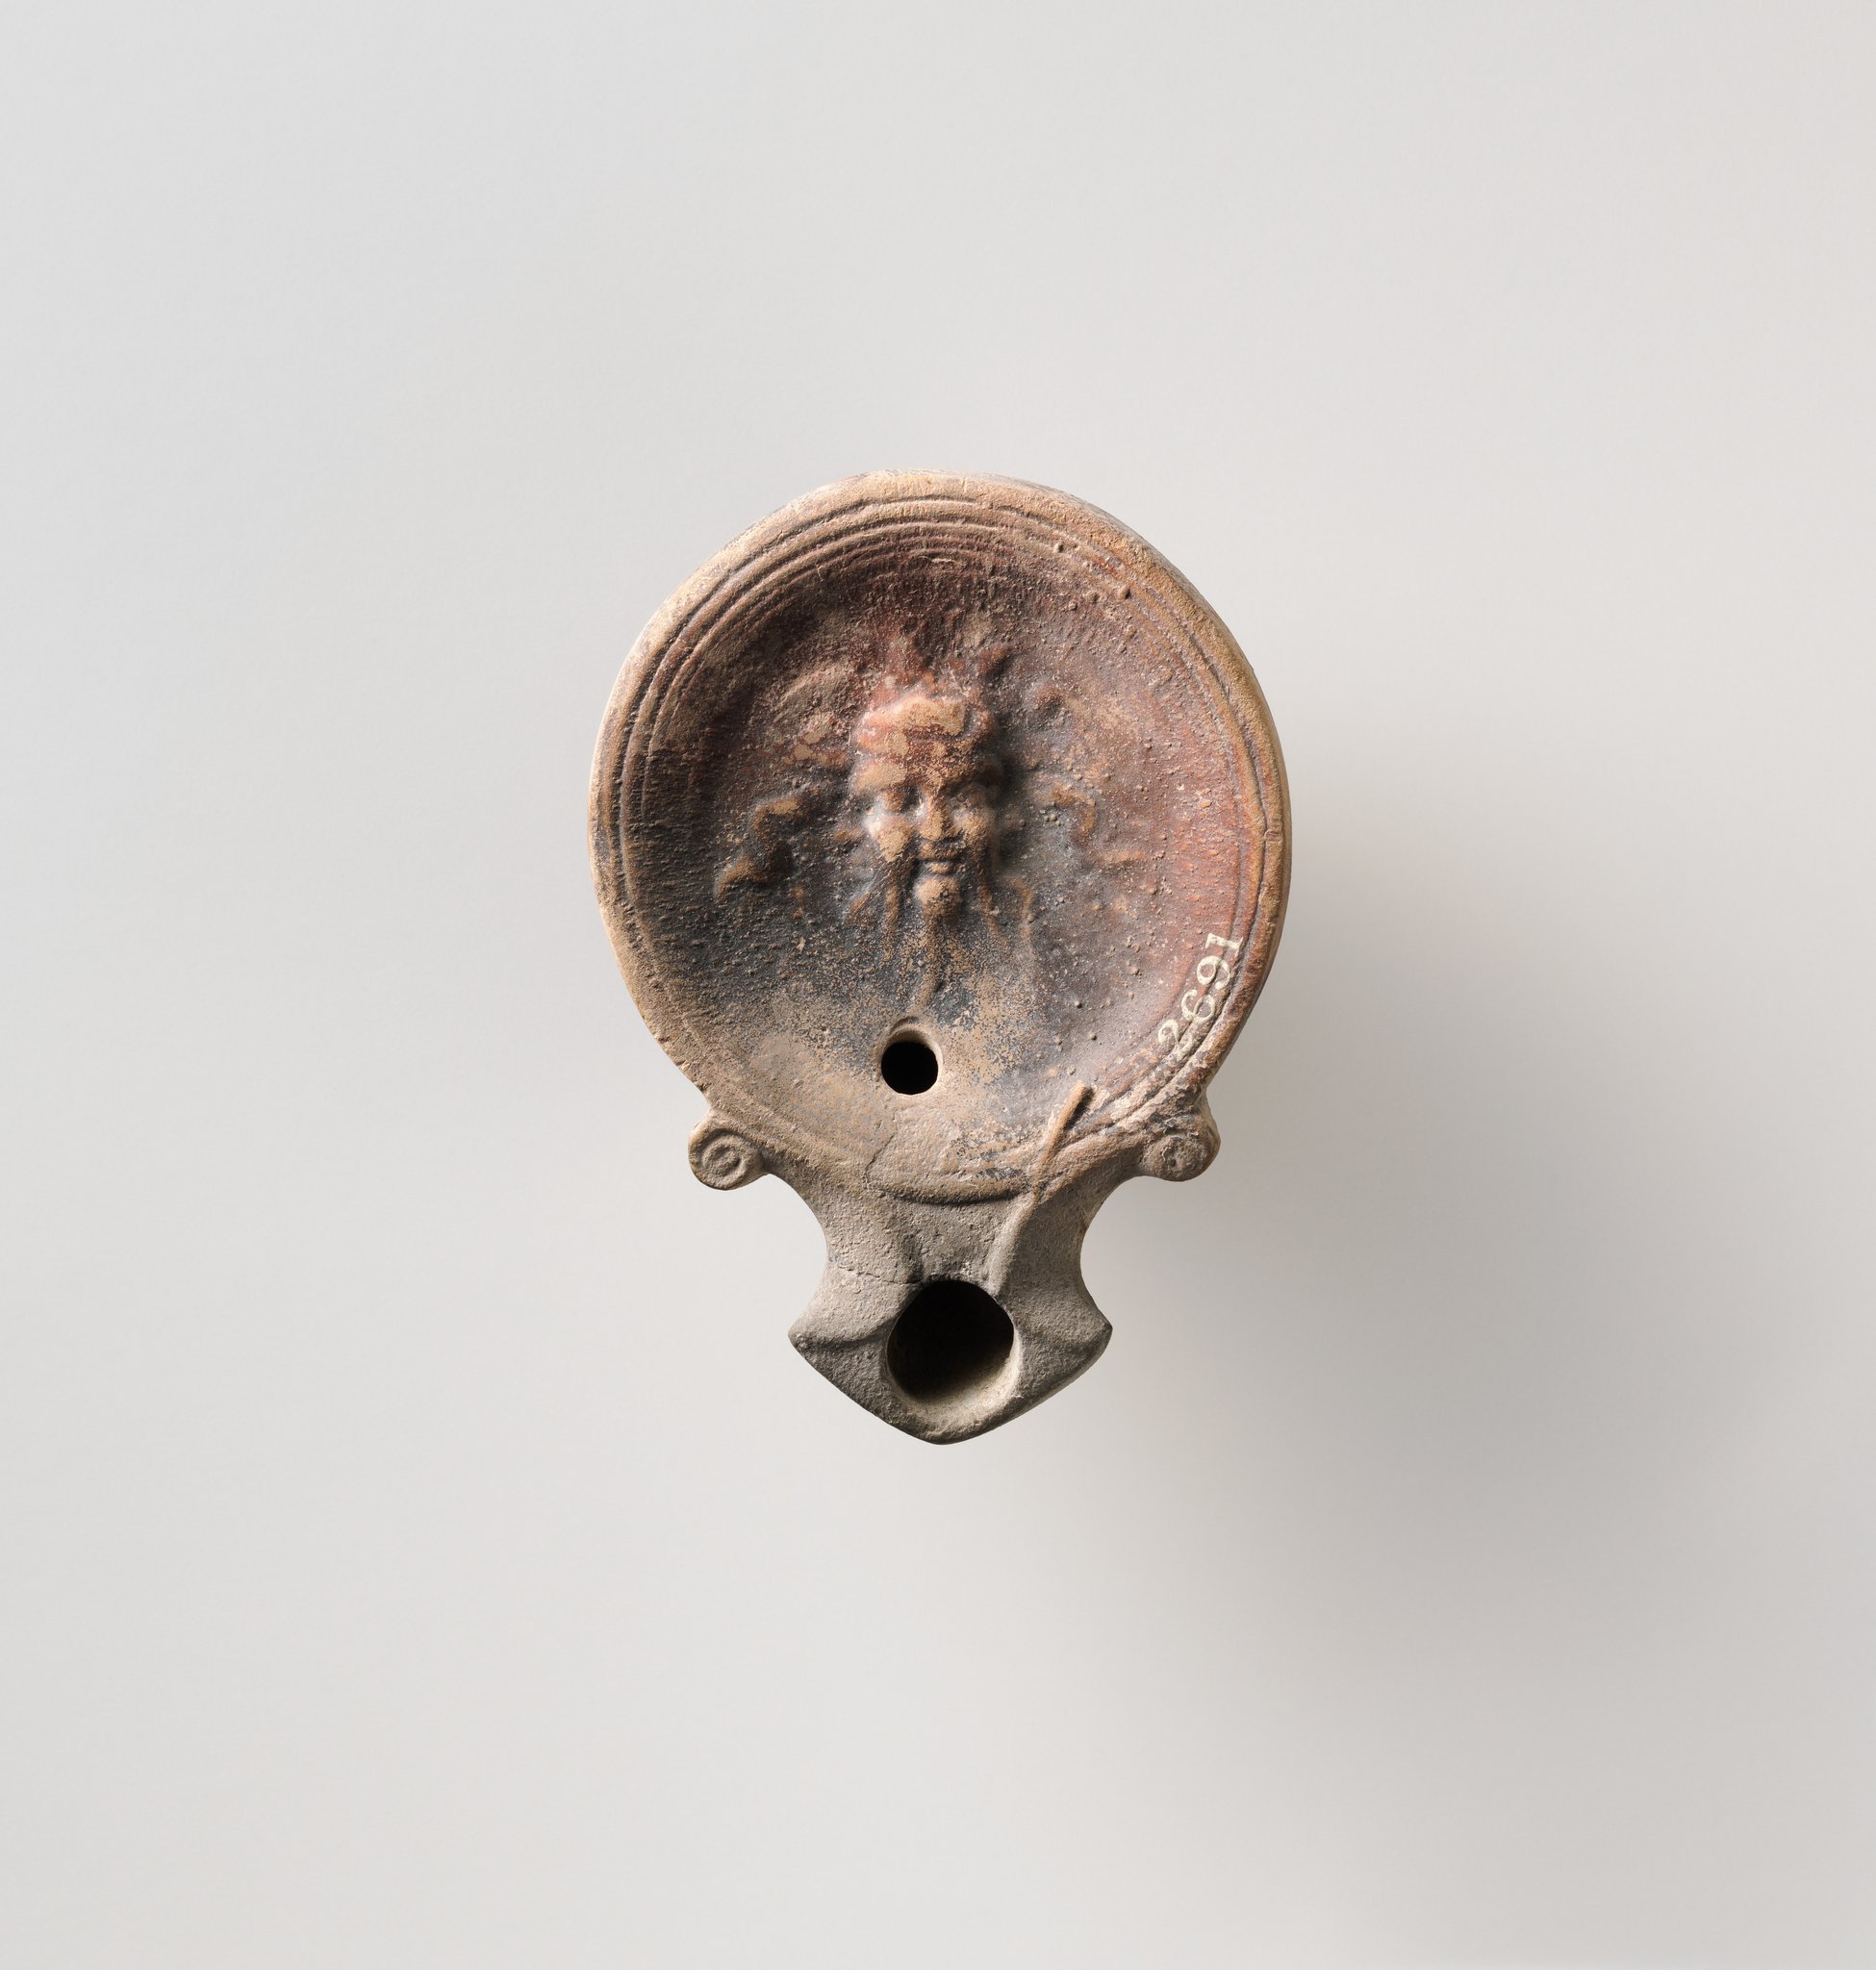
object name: lamp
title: Terracotta oil lamp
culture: roman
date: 100 BCE-100 CE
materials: terracotta